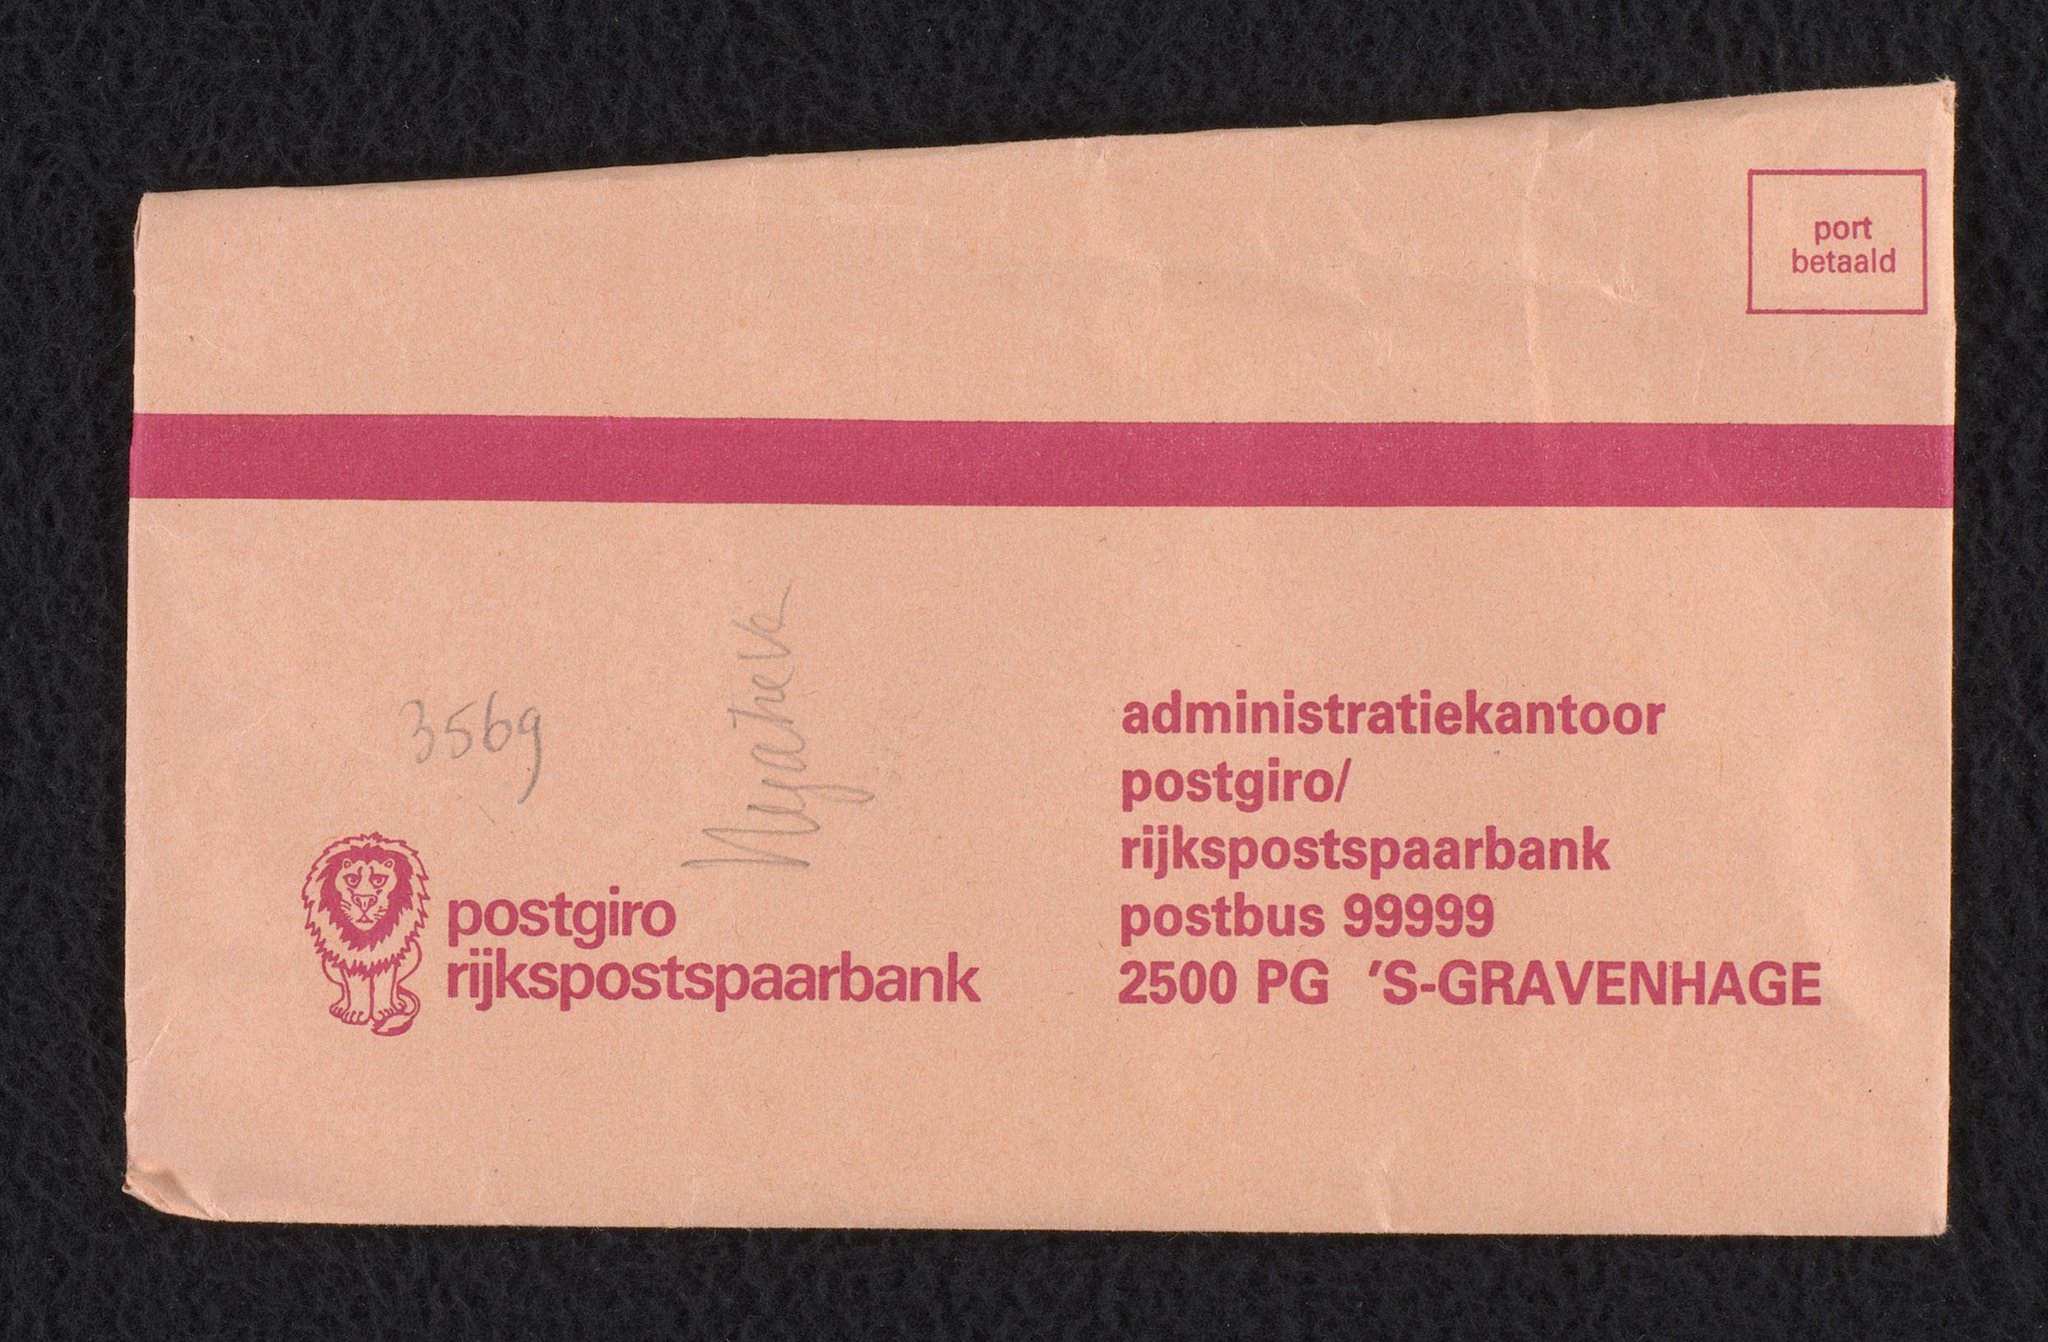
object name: filmnegatief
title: 128 negatieven met opnamen van portretten van onbekende personen en landschappen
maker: Anonymous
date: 1890-1920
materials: film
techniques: gelatin silver negative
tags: beach (as place of recreation), the family travelling, on holiday, historical persons not known by name, mountains, netherlands, italy, amsterdam, switzerland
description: Tachtig kleine negatieven, twee middelgrote negatieven en 46 grote negatieven.